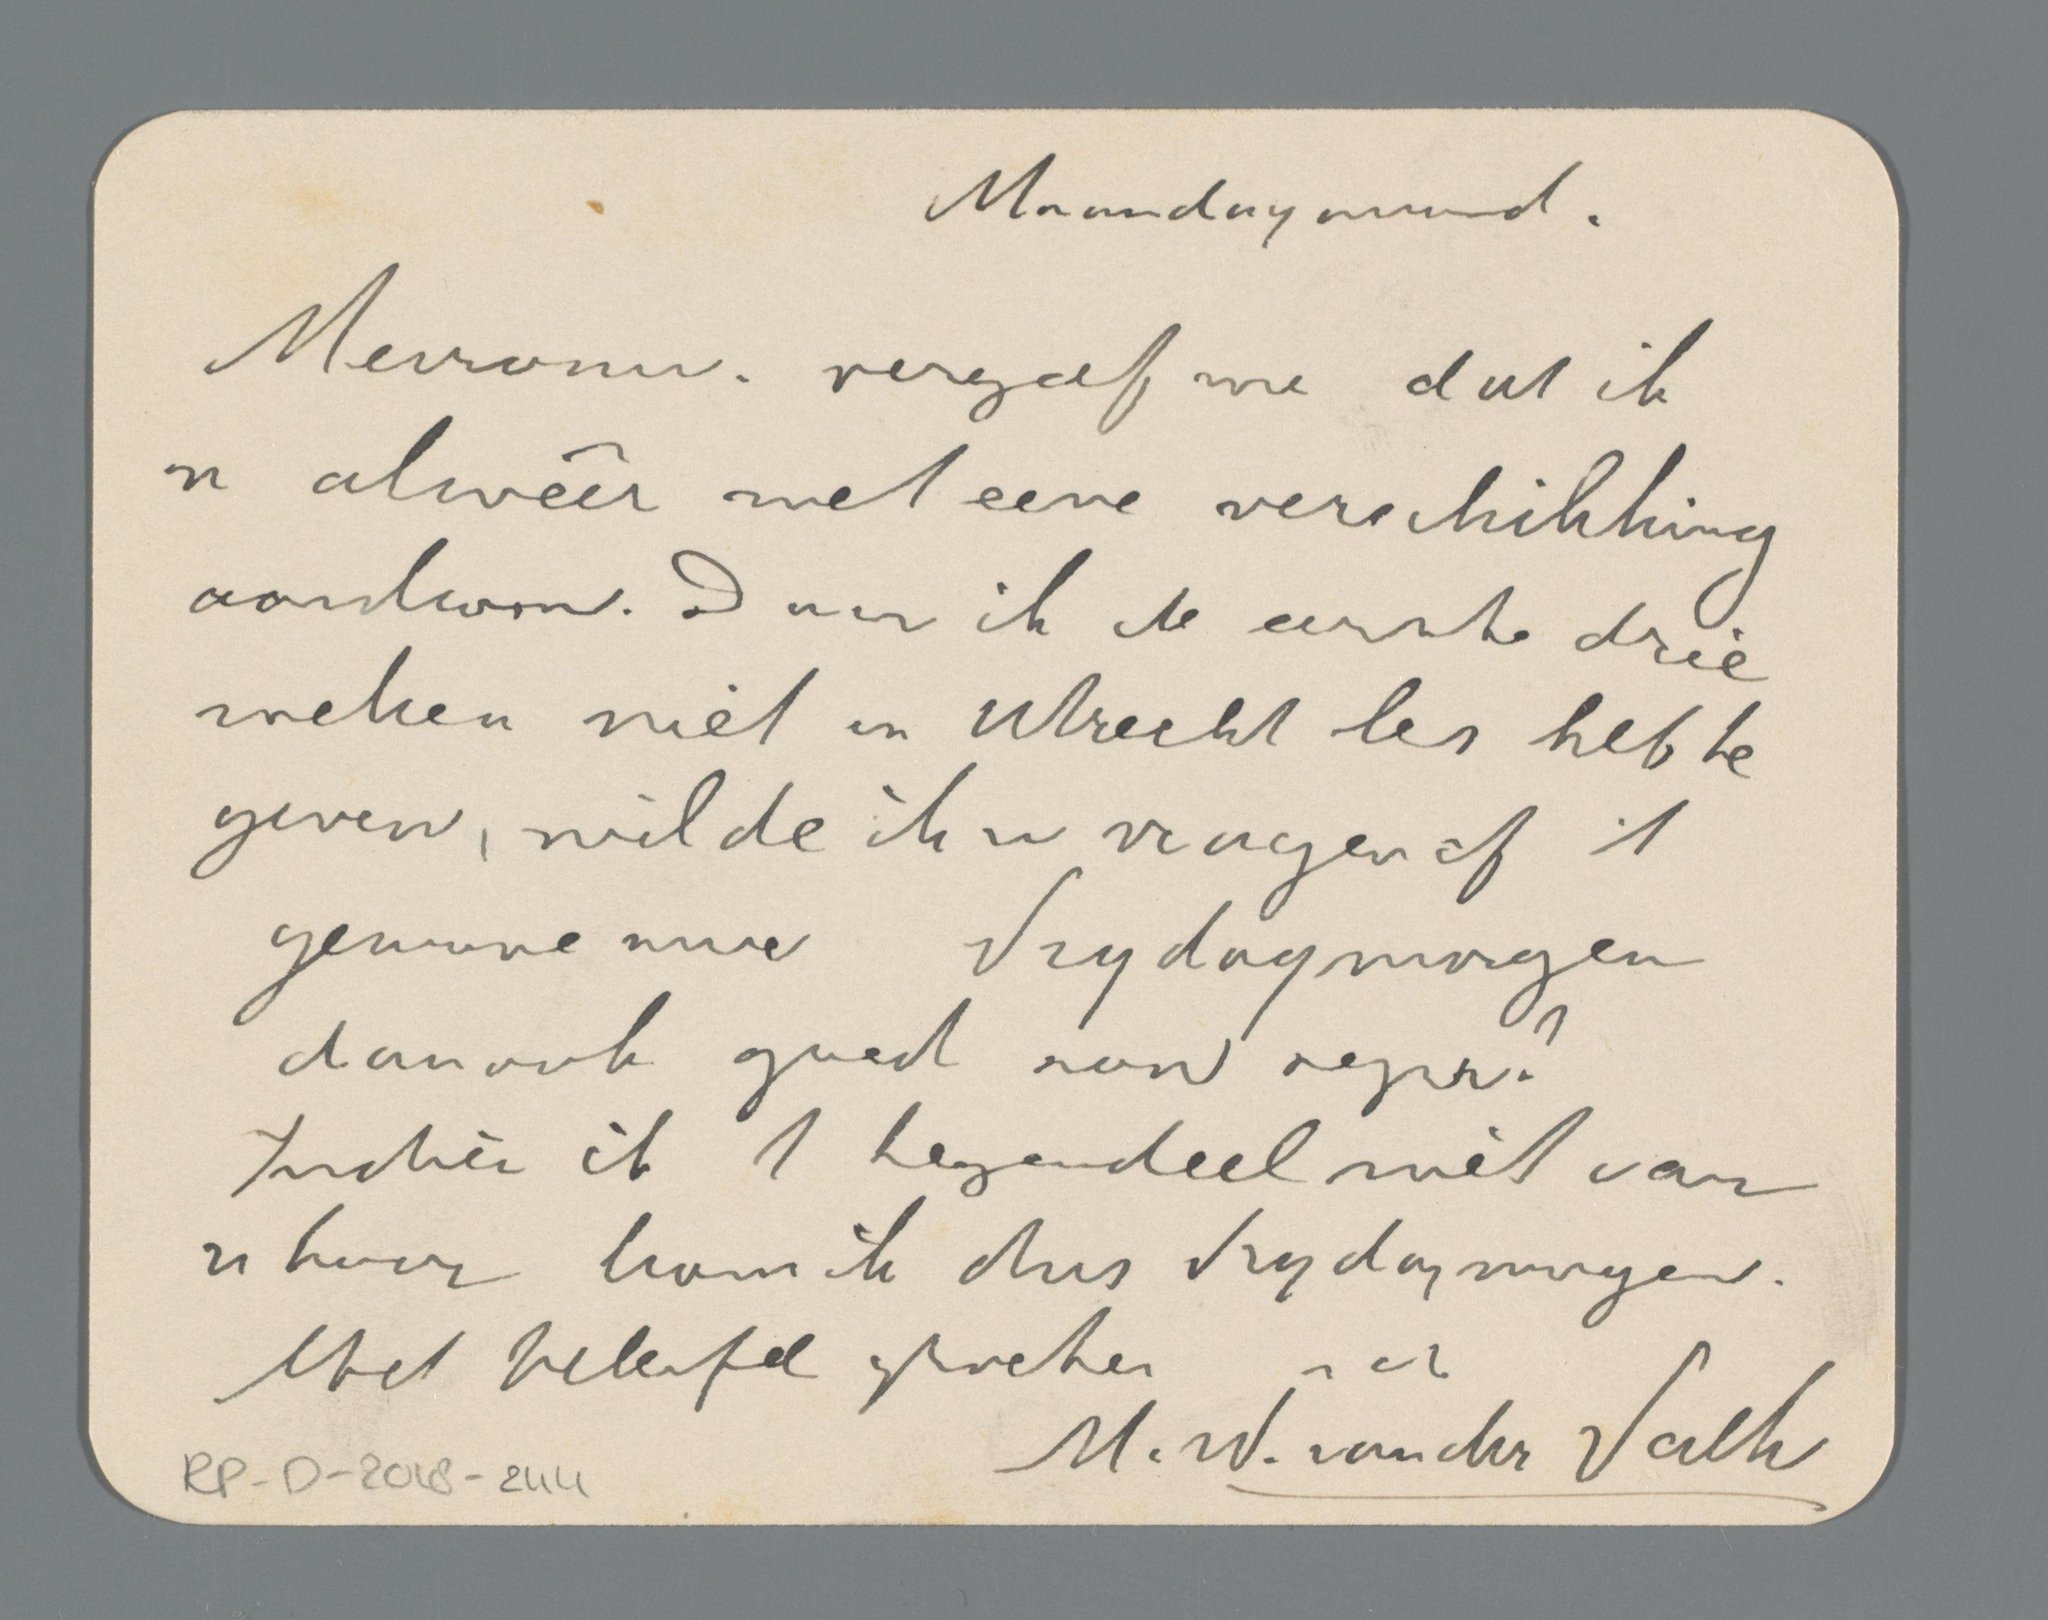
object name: postcard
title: Briefkaart aan Jeannette Bouman-Stuyling de Lange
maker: maurits van der valk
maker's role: draughtsman, print maker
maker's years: 1857-1935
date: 1899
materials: cardboard, ink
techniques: pen, writing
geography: amsterdam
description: Briefkaart gericht aan Mevrouw Bouman de Lange, van Scholkweg, Villa Vineta, Scheveningen.